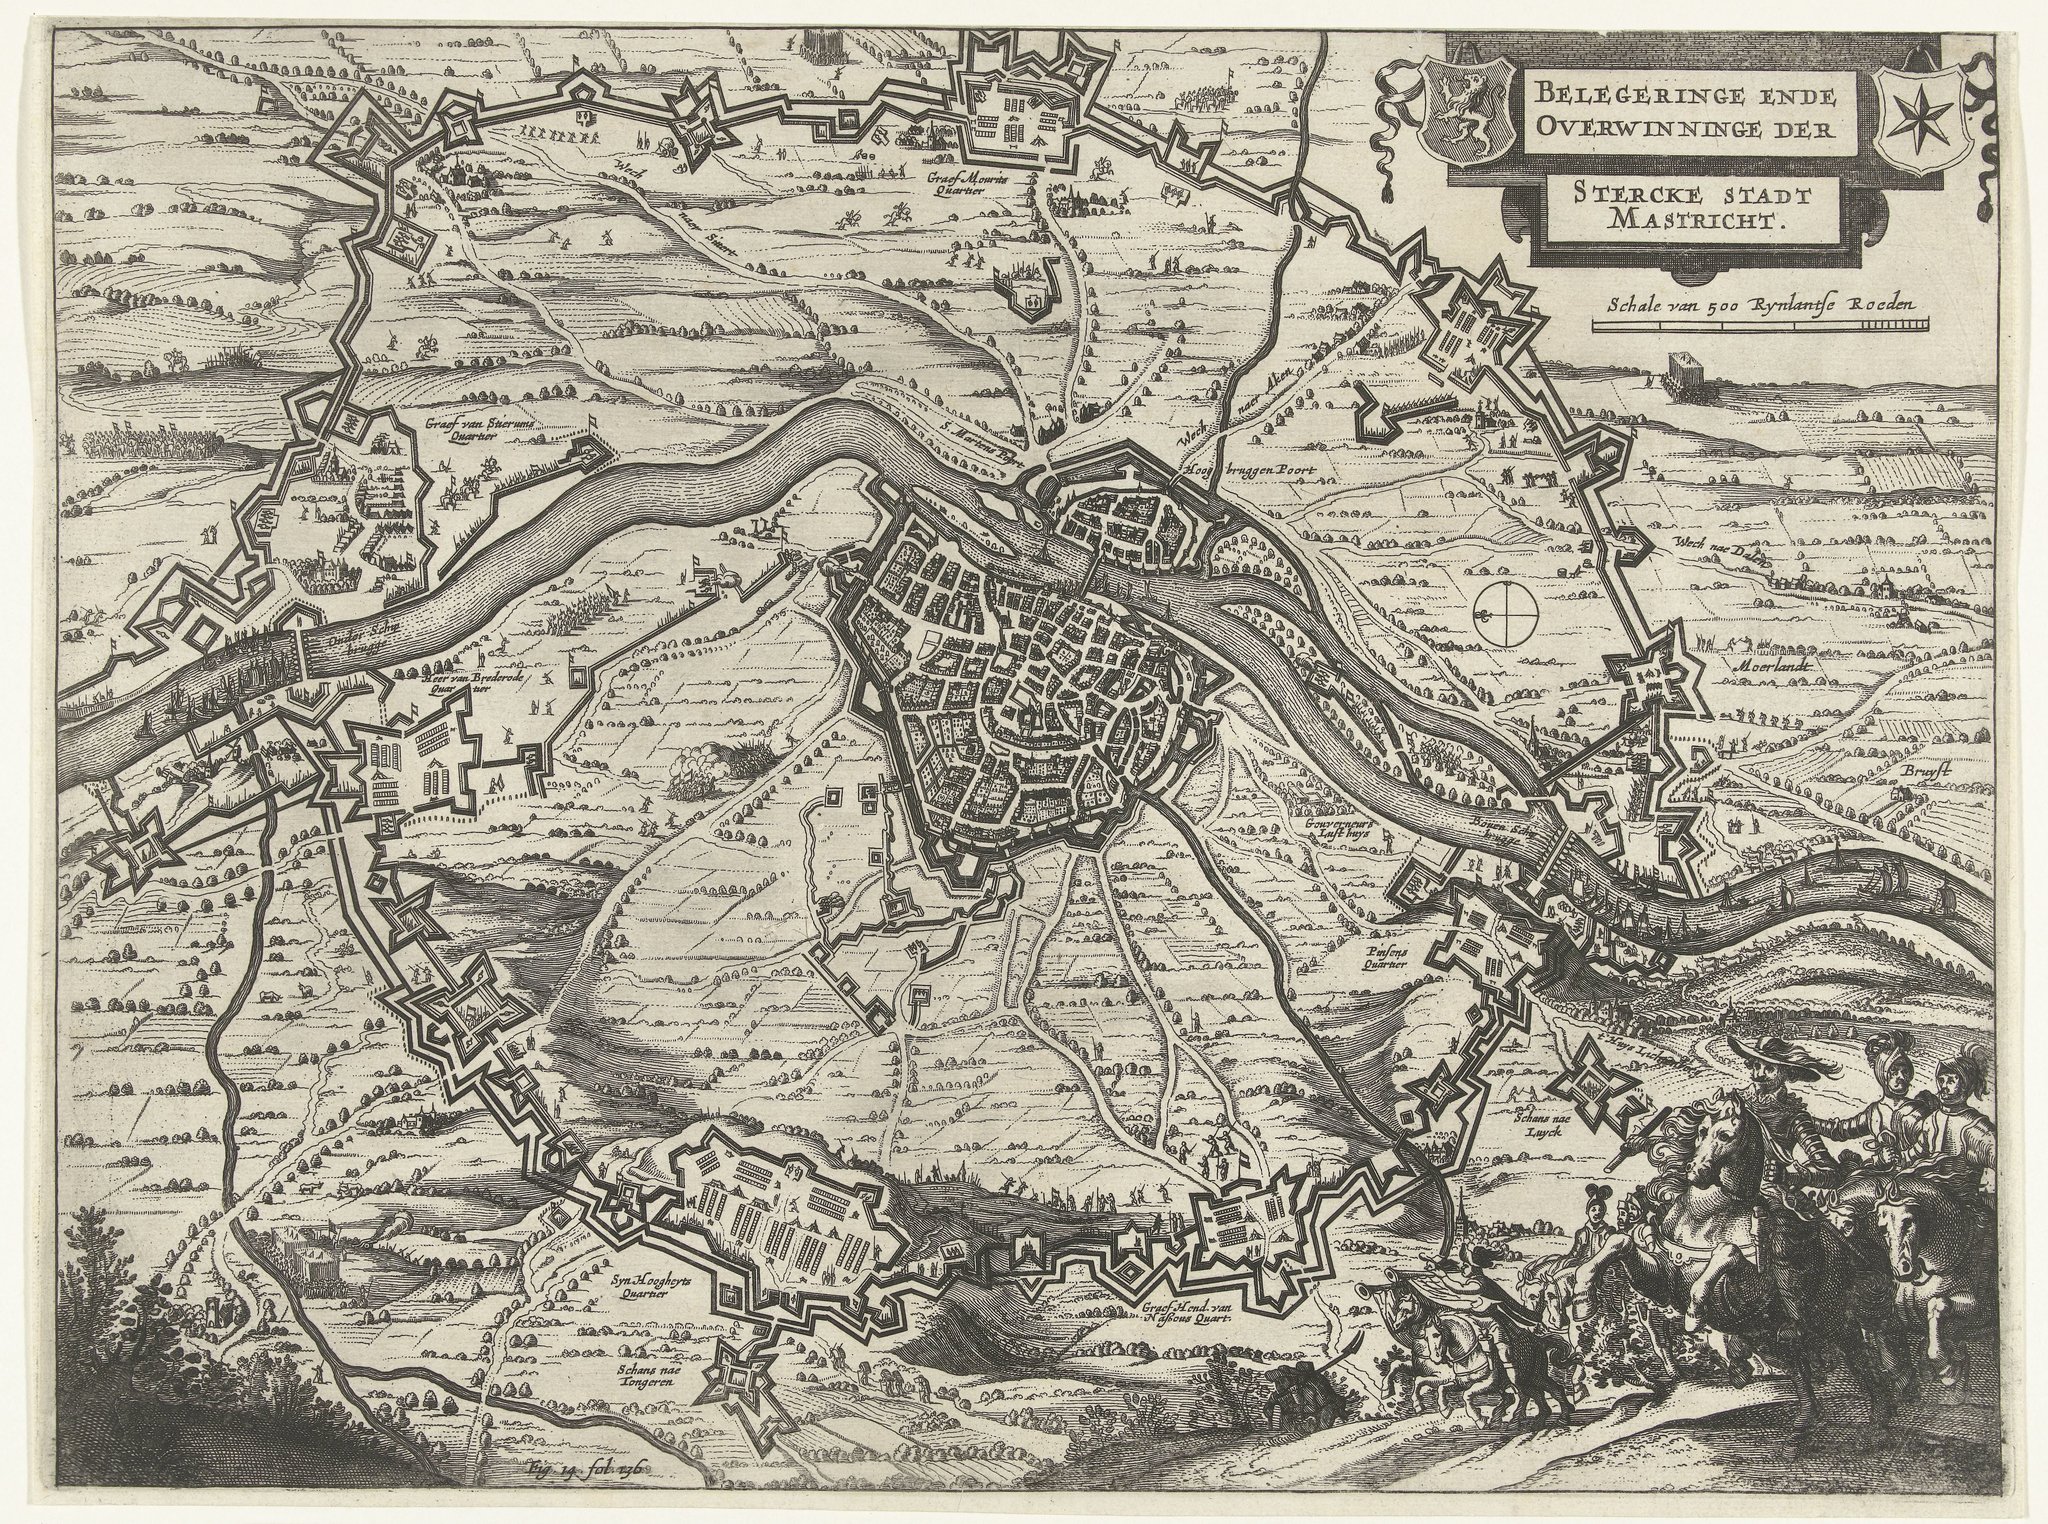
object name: print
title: Belegering van Maastricht, 1632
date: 1649-1651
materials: paper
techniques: etching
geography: northern netherlands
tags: delft, the hague, frederick henry (prince of orange), maps of separate countries or regions, siege, position war, maps of cities, maastricht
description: Kaart van het beleg van Maastricht door het Staatse leger onder stadhouder Frederik Hendrik, 9 juni tot 21 augustus 1632. Omsingeling van de stad met de verschillende legerkampen van de belegeraars. Rechtsonder de stadhouder met officieren te paard. Gemerkt linksonder: Fig. 14 fol. 136.